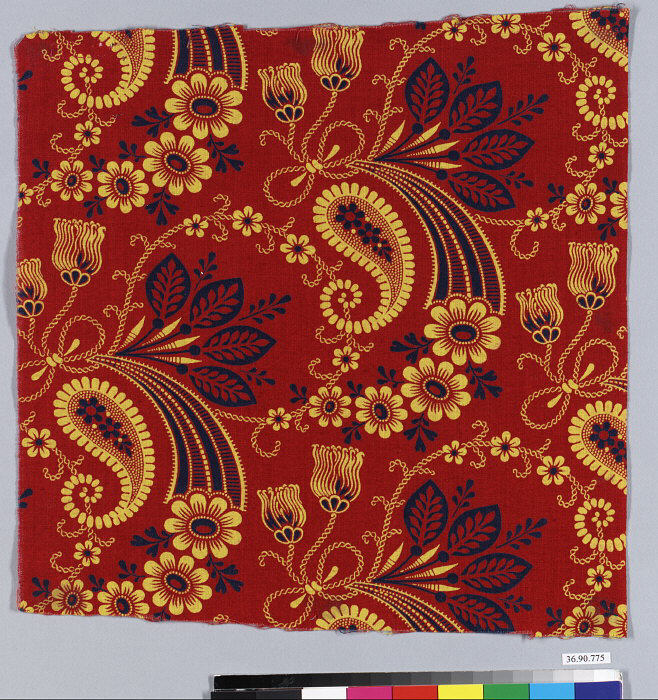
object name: piece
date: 1867-1900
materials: cotton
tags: flowers